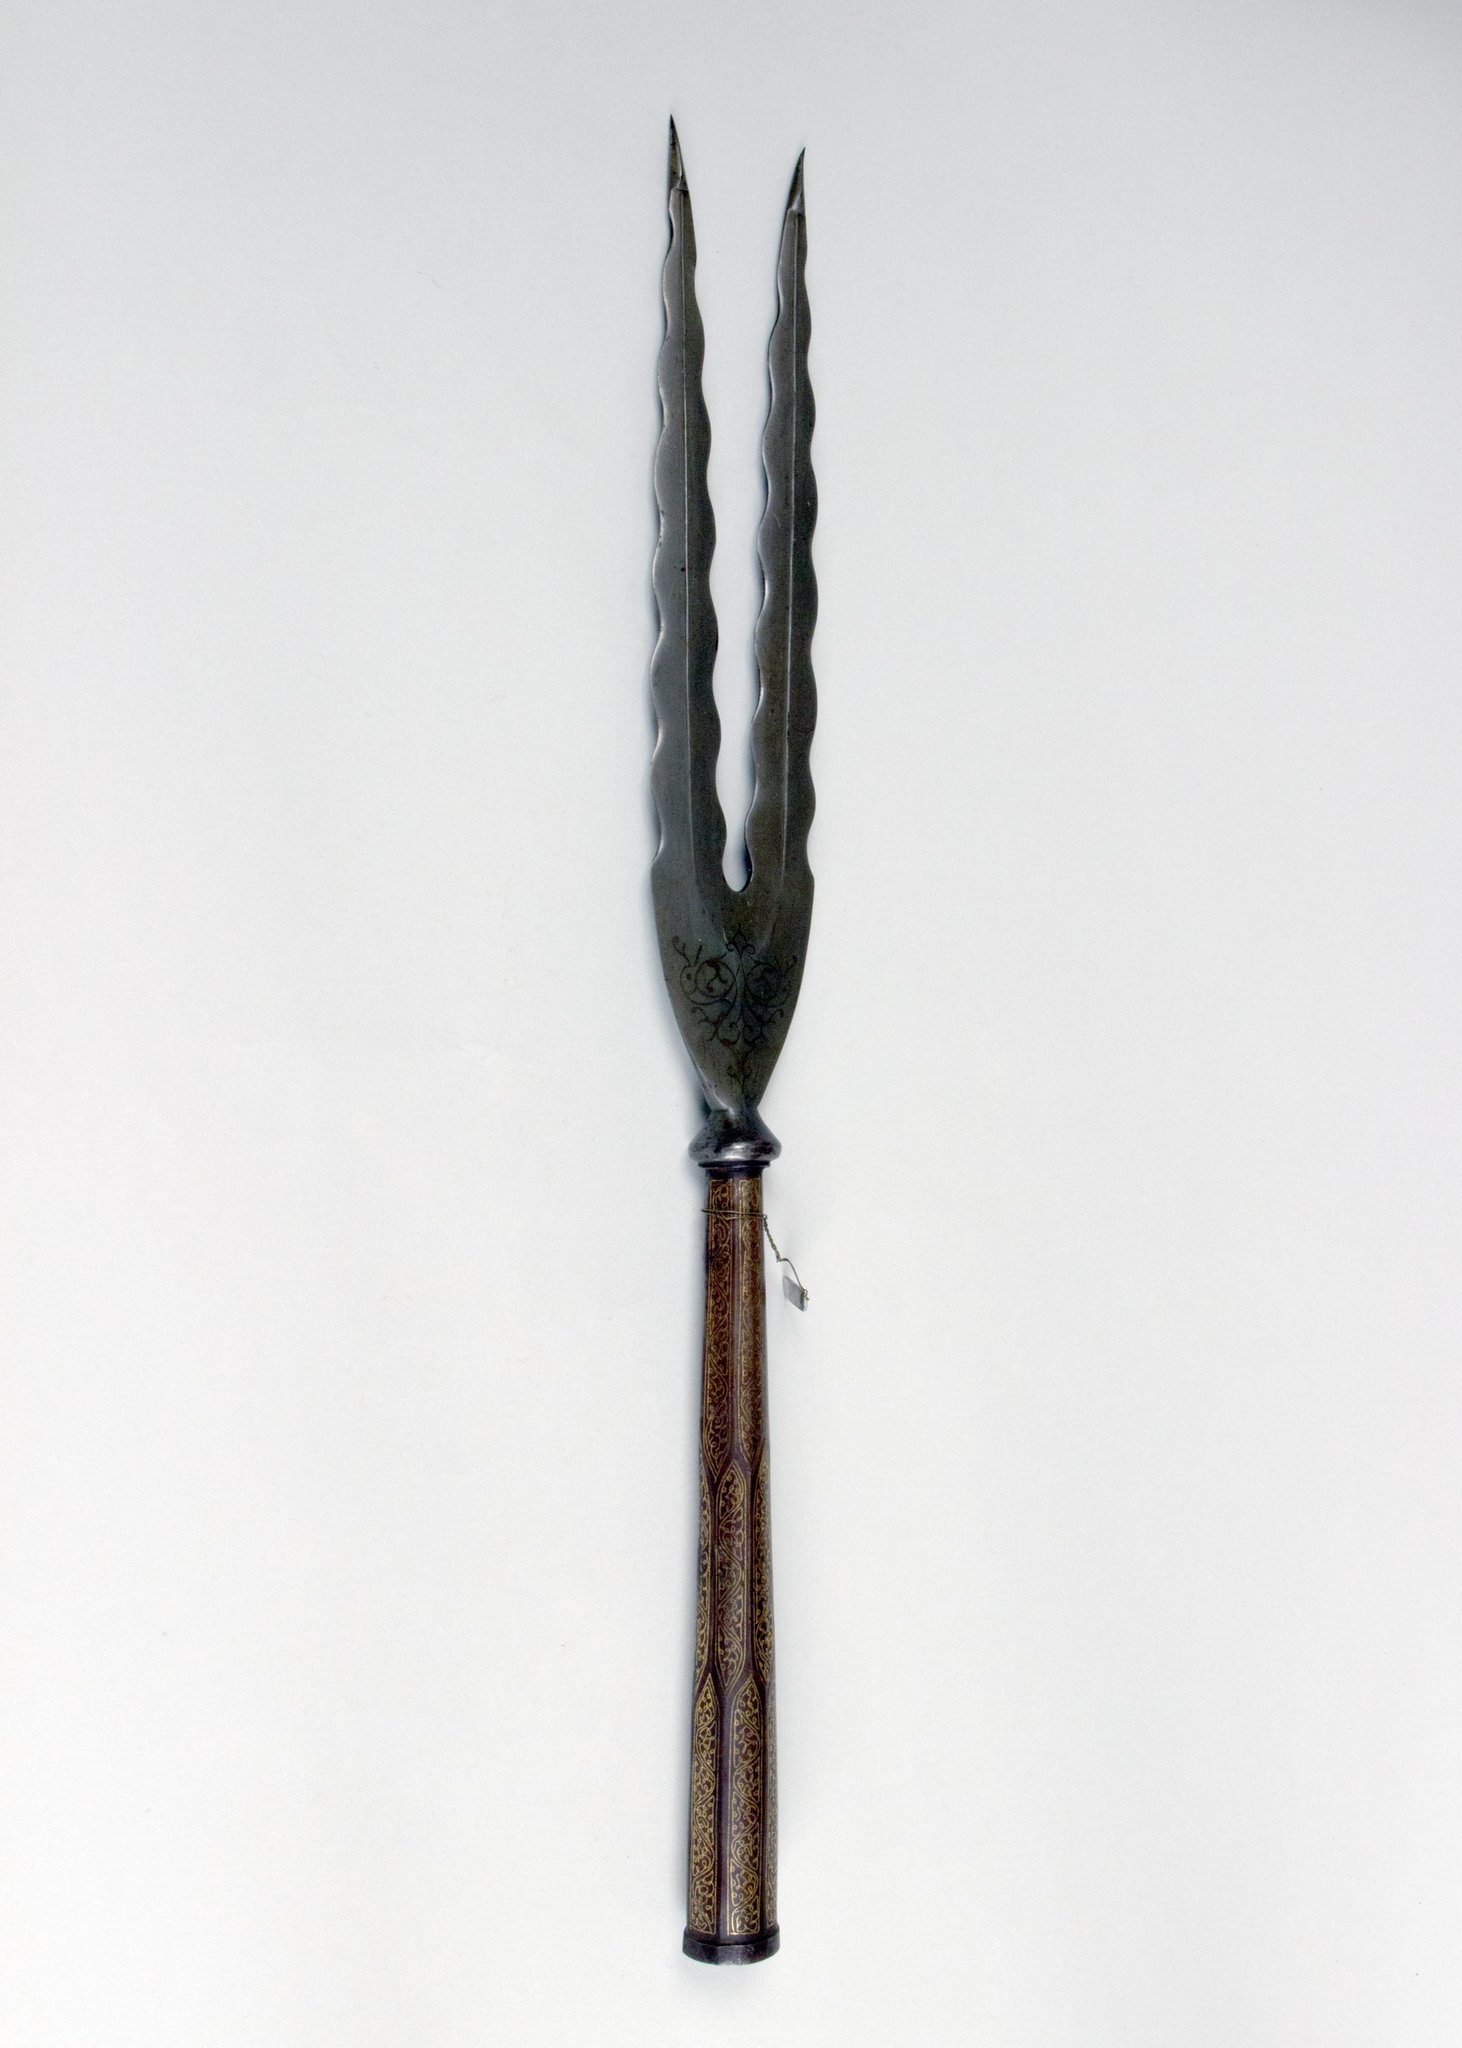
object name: spearhead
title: Bident Spearhead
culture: persian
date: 1801-1900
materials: gold, steel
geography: iran